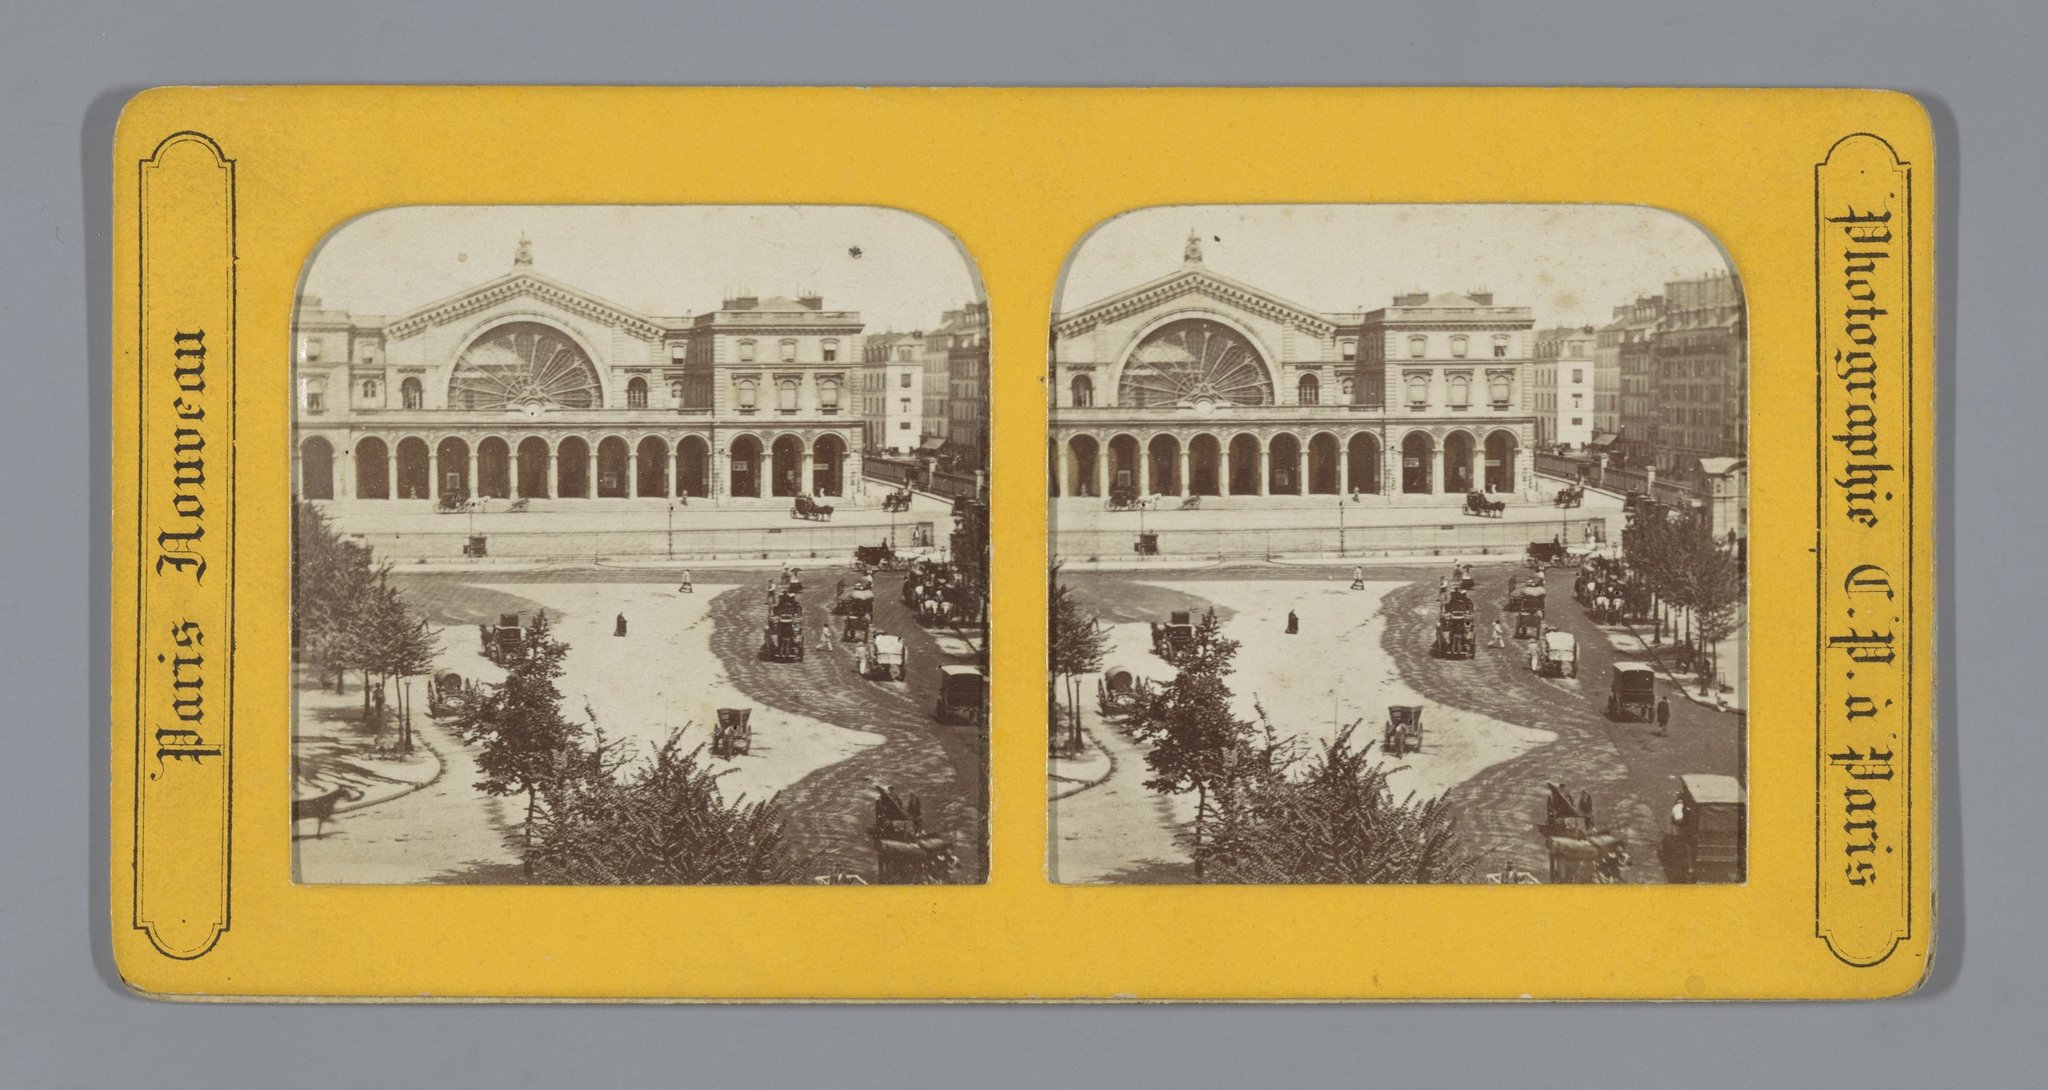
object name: tissue stereograph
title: Paris Nouveau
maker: monogrammist cp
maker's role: fotograaf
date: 1858-1875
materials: cardboard, paper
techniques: albumen print, cutting, hand coloring, perforating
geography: paris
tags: square, place, circus, etc., station; shelter (railway, tramway)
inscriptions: collector's mark: ‘J. C. de Beste Wz./ Goes’